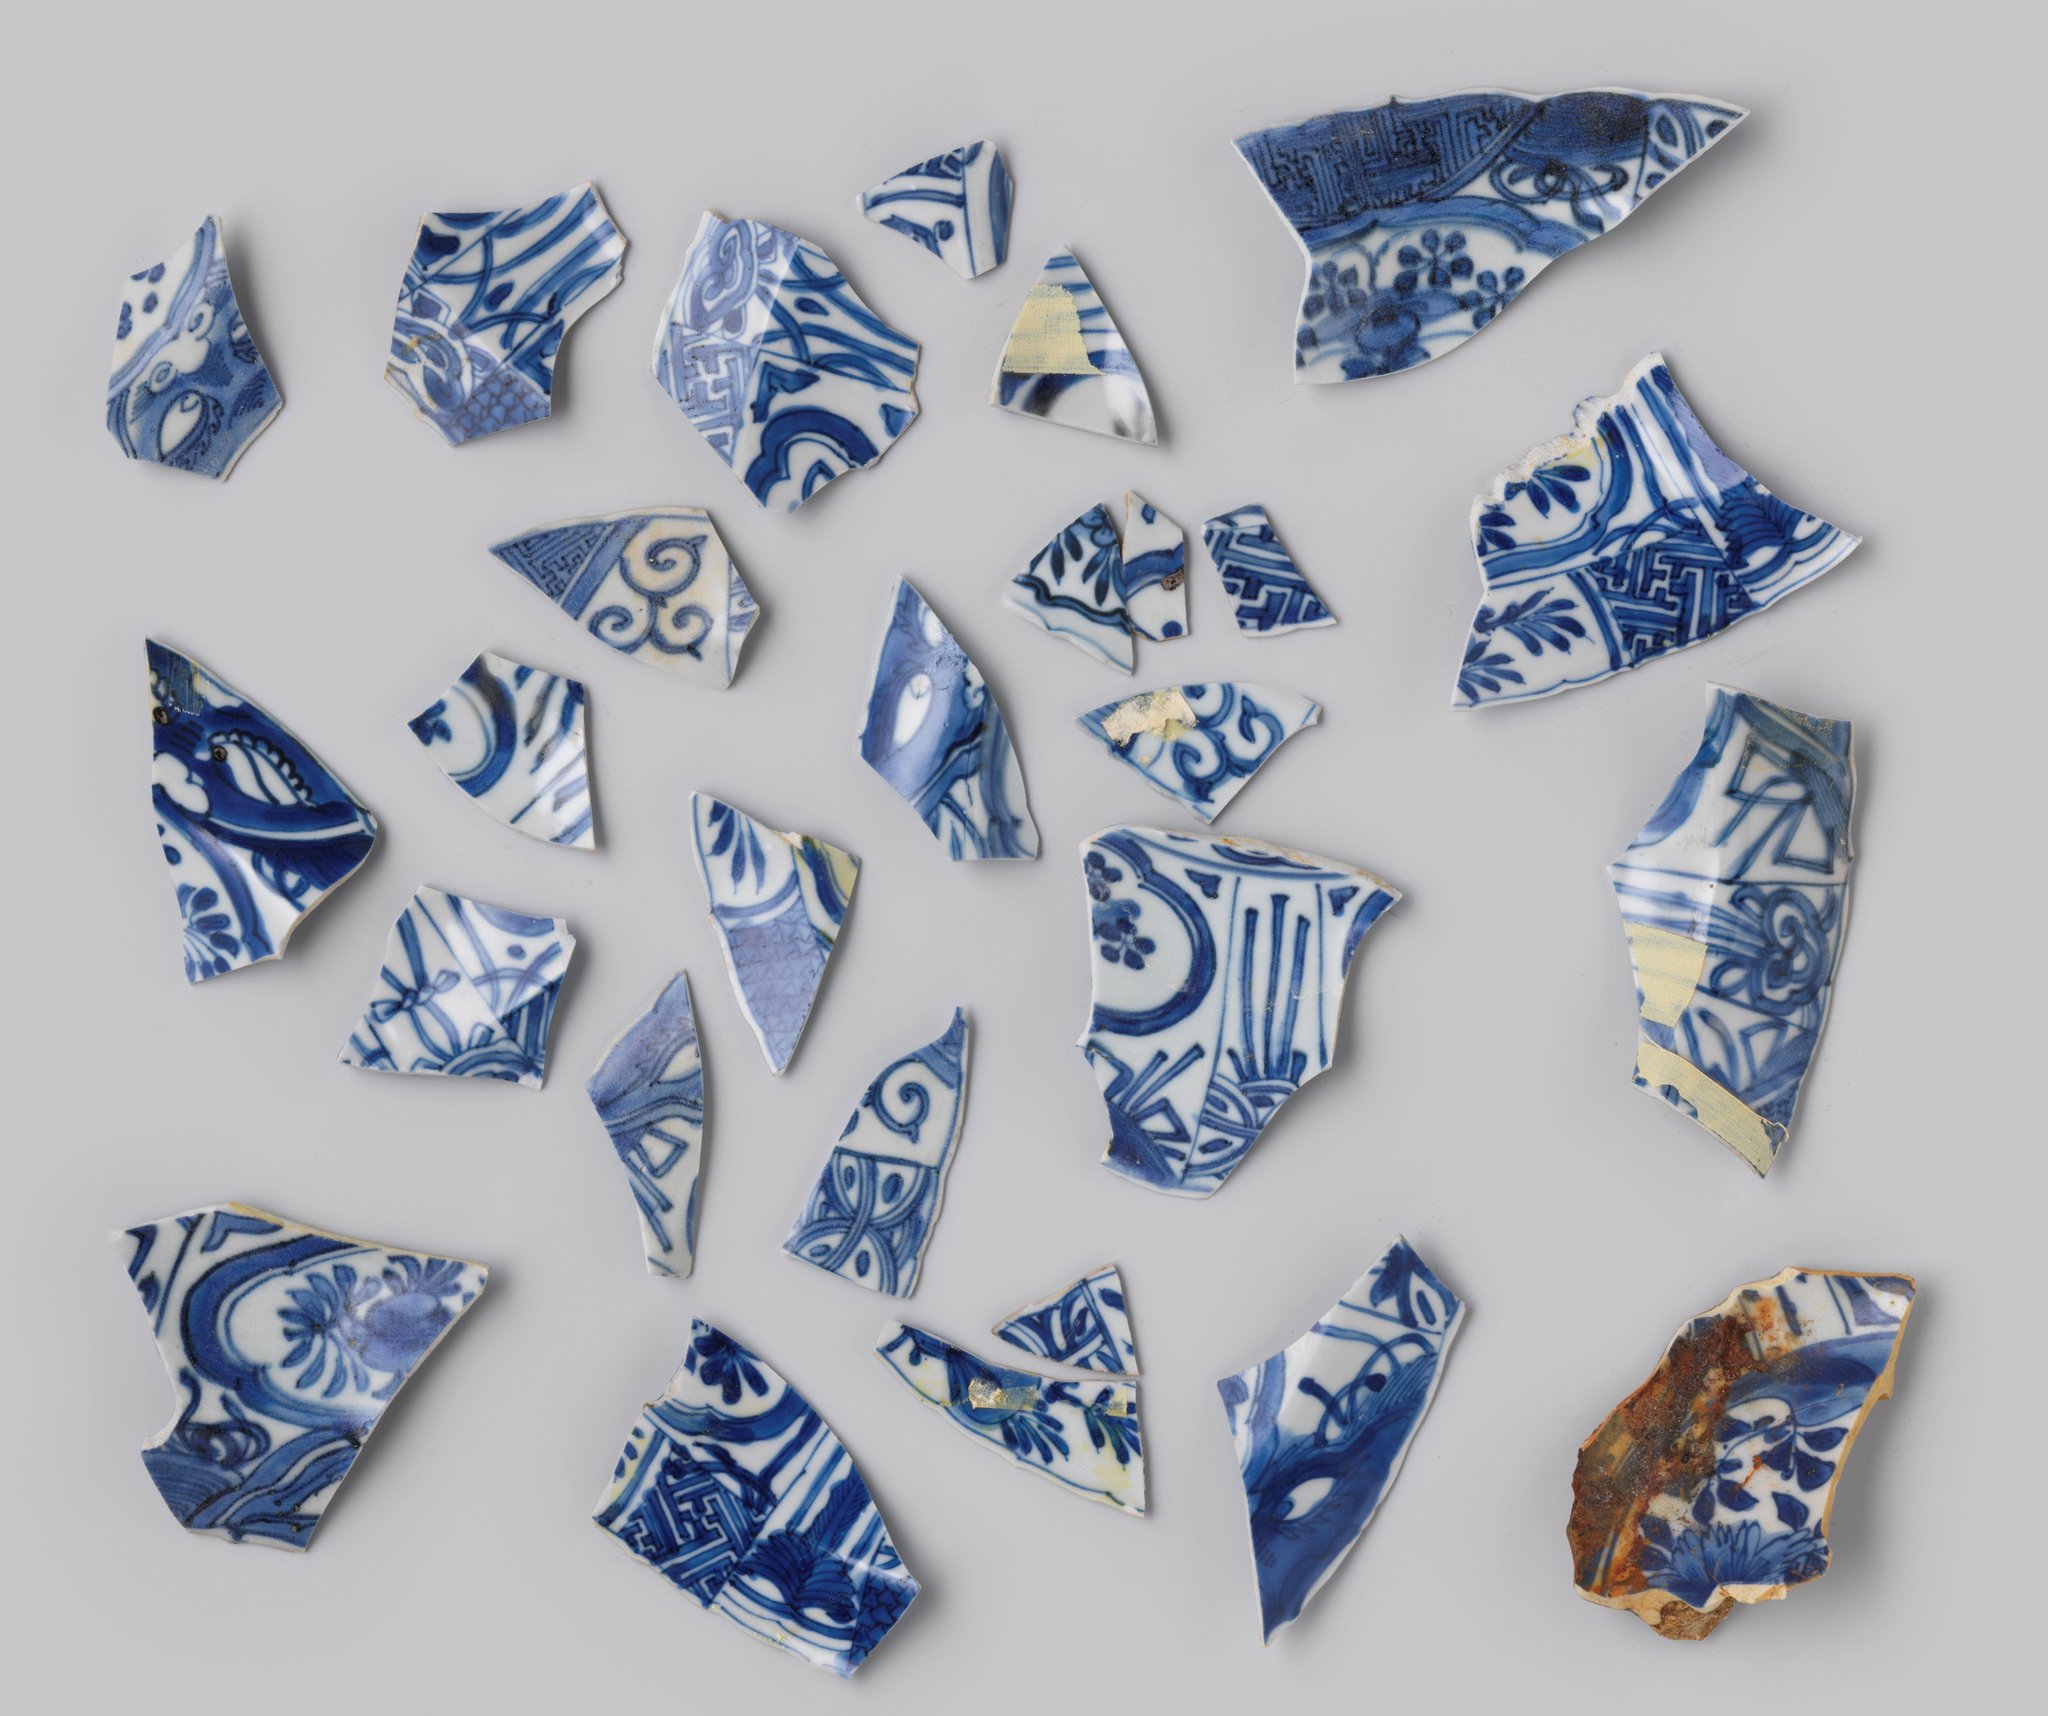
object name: sherd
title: Scherven van borden uit V.O.C.-schip de 'Witte Leeuw'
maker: Anonymous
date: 1613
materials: bone china, stone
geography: jingdezhen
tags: verenigde oostindische compagnie, sint-helena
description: Scherven van borden uit V.O.C.-schip de 'Witte Leeuw'. Eén scherf vast aan brok concretie.